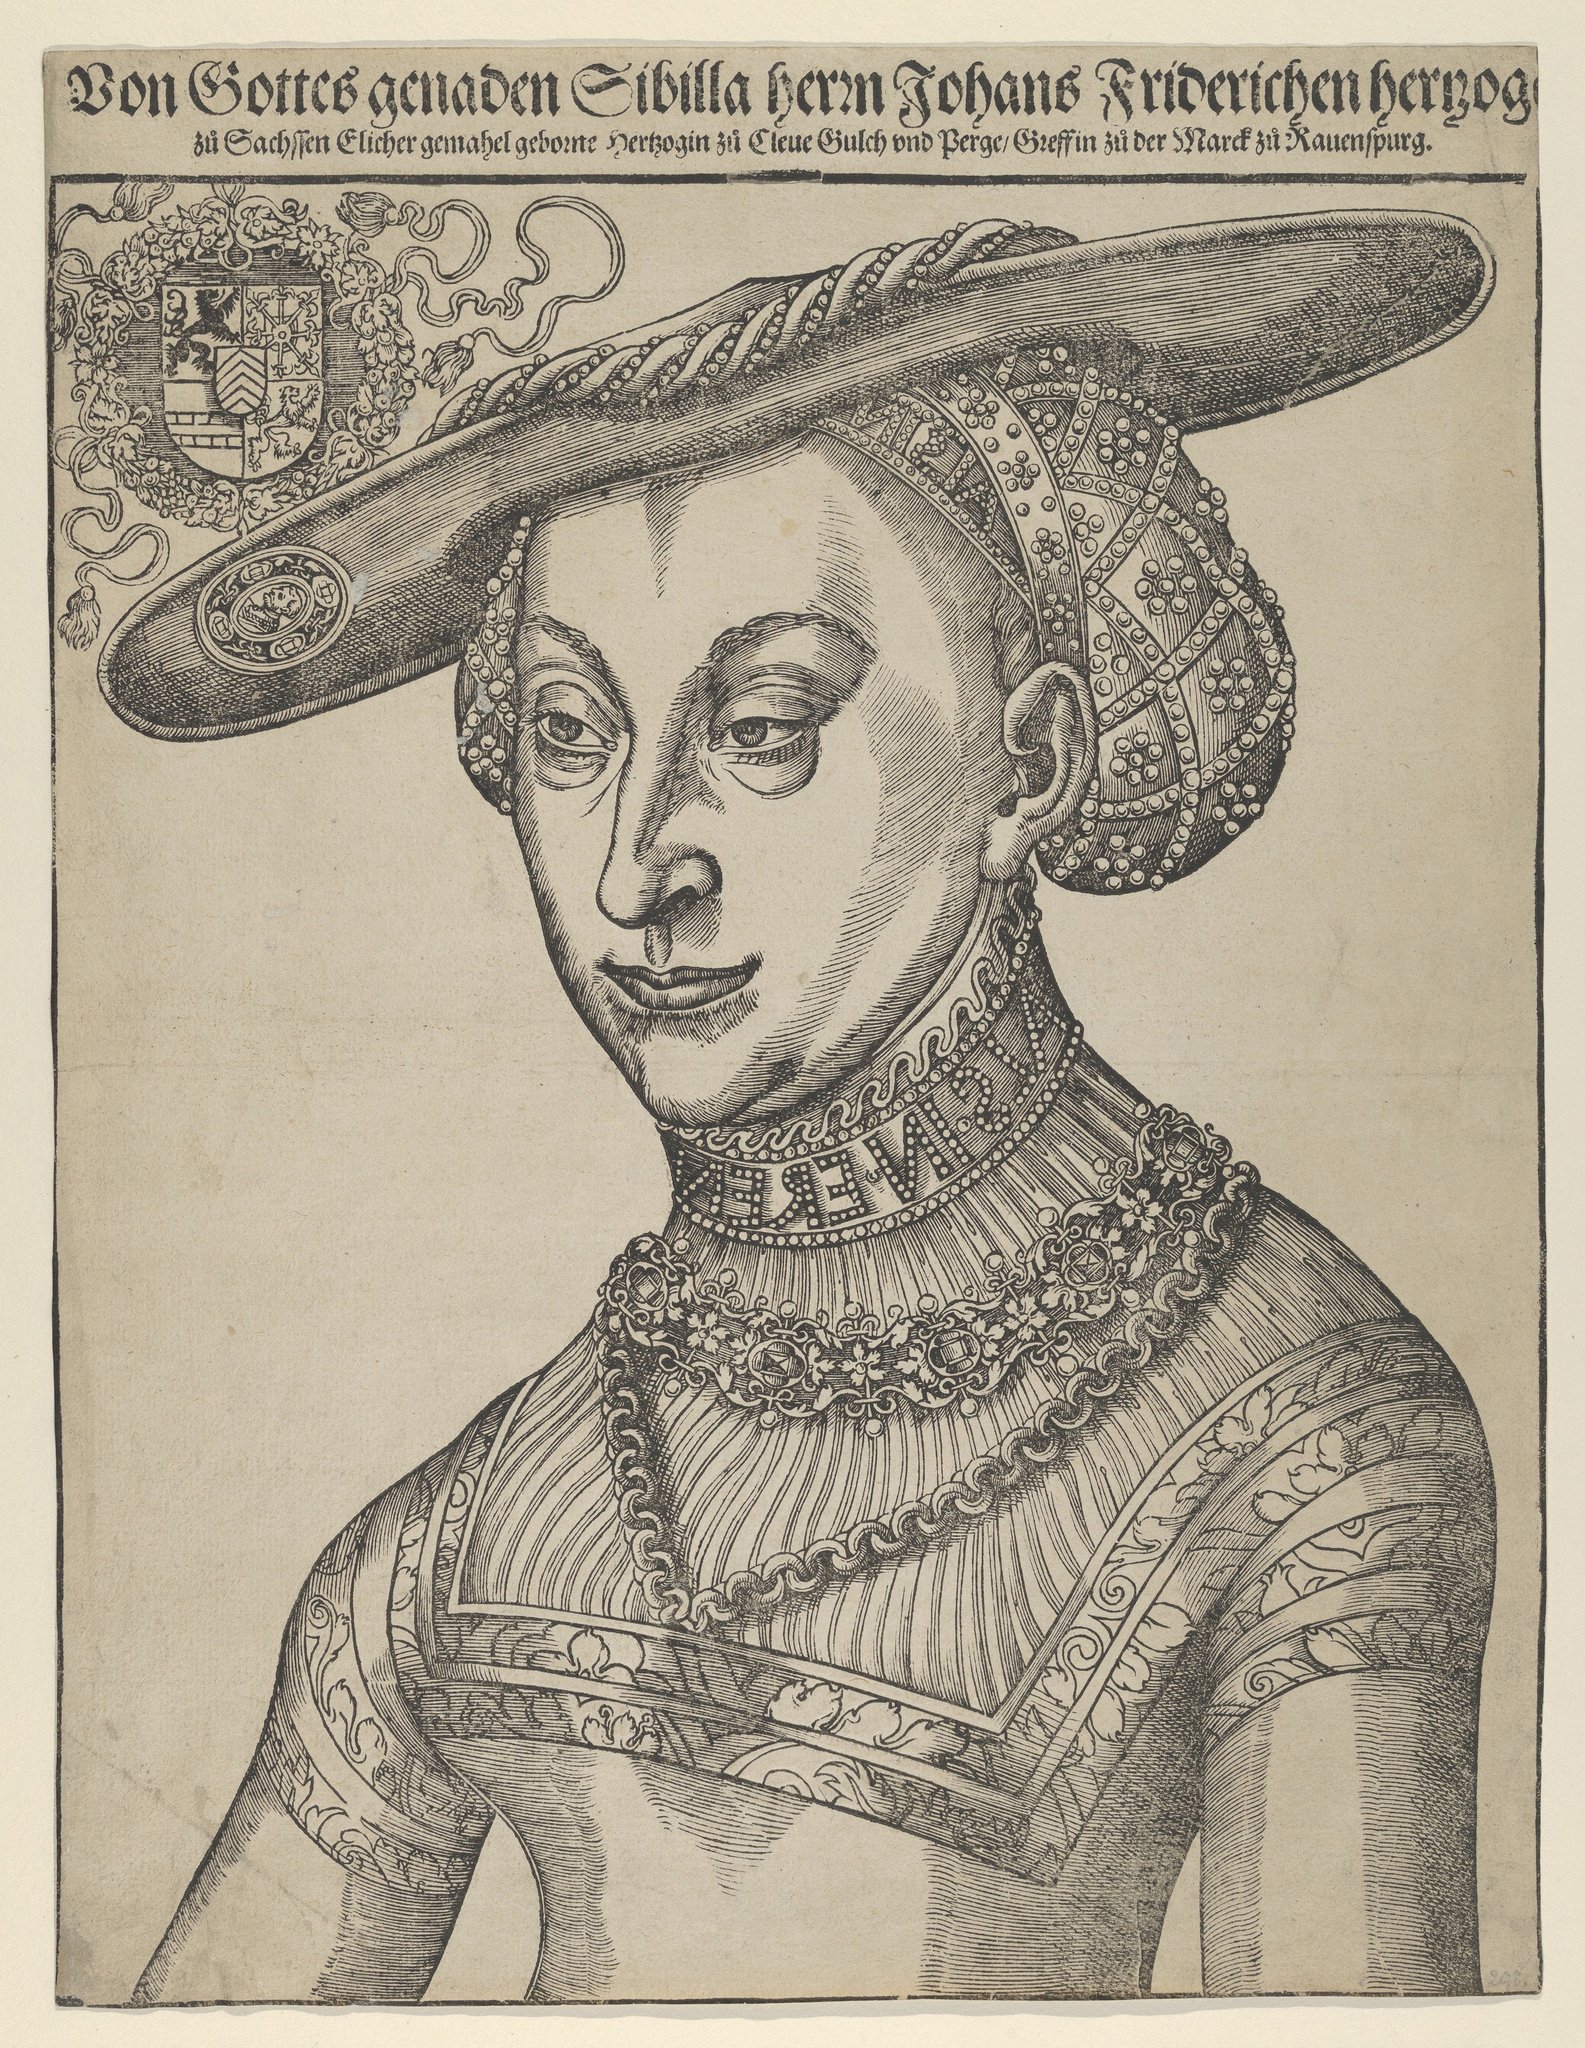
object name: print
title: Sybilla of Cleves, Wife of John Frederic of Saxony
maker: lucas cranach the elder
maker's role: artist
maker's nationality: german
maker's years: 1472-1553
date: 1472-1553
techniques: woodcut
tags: portraits,women,coat of arms